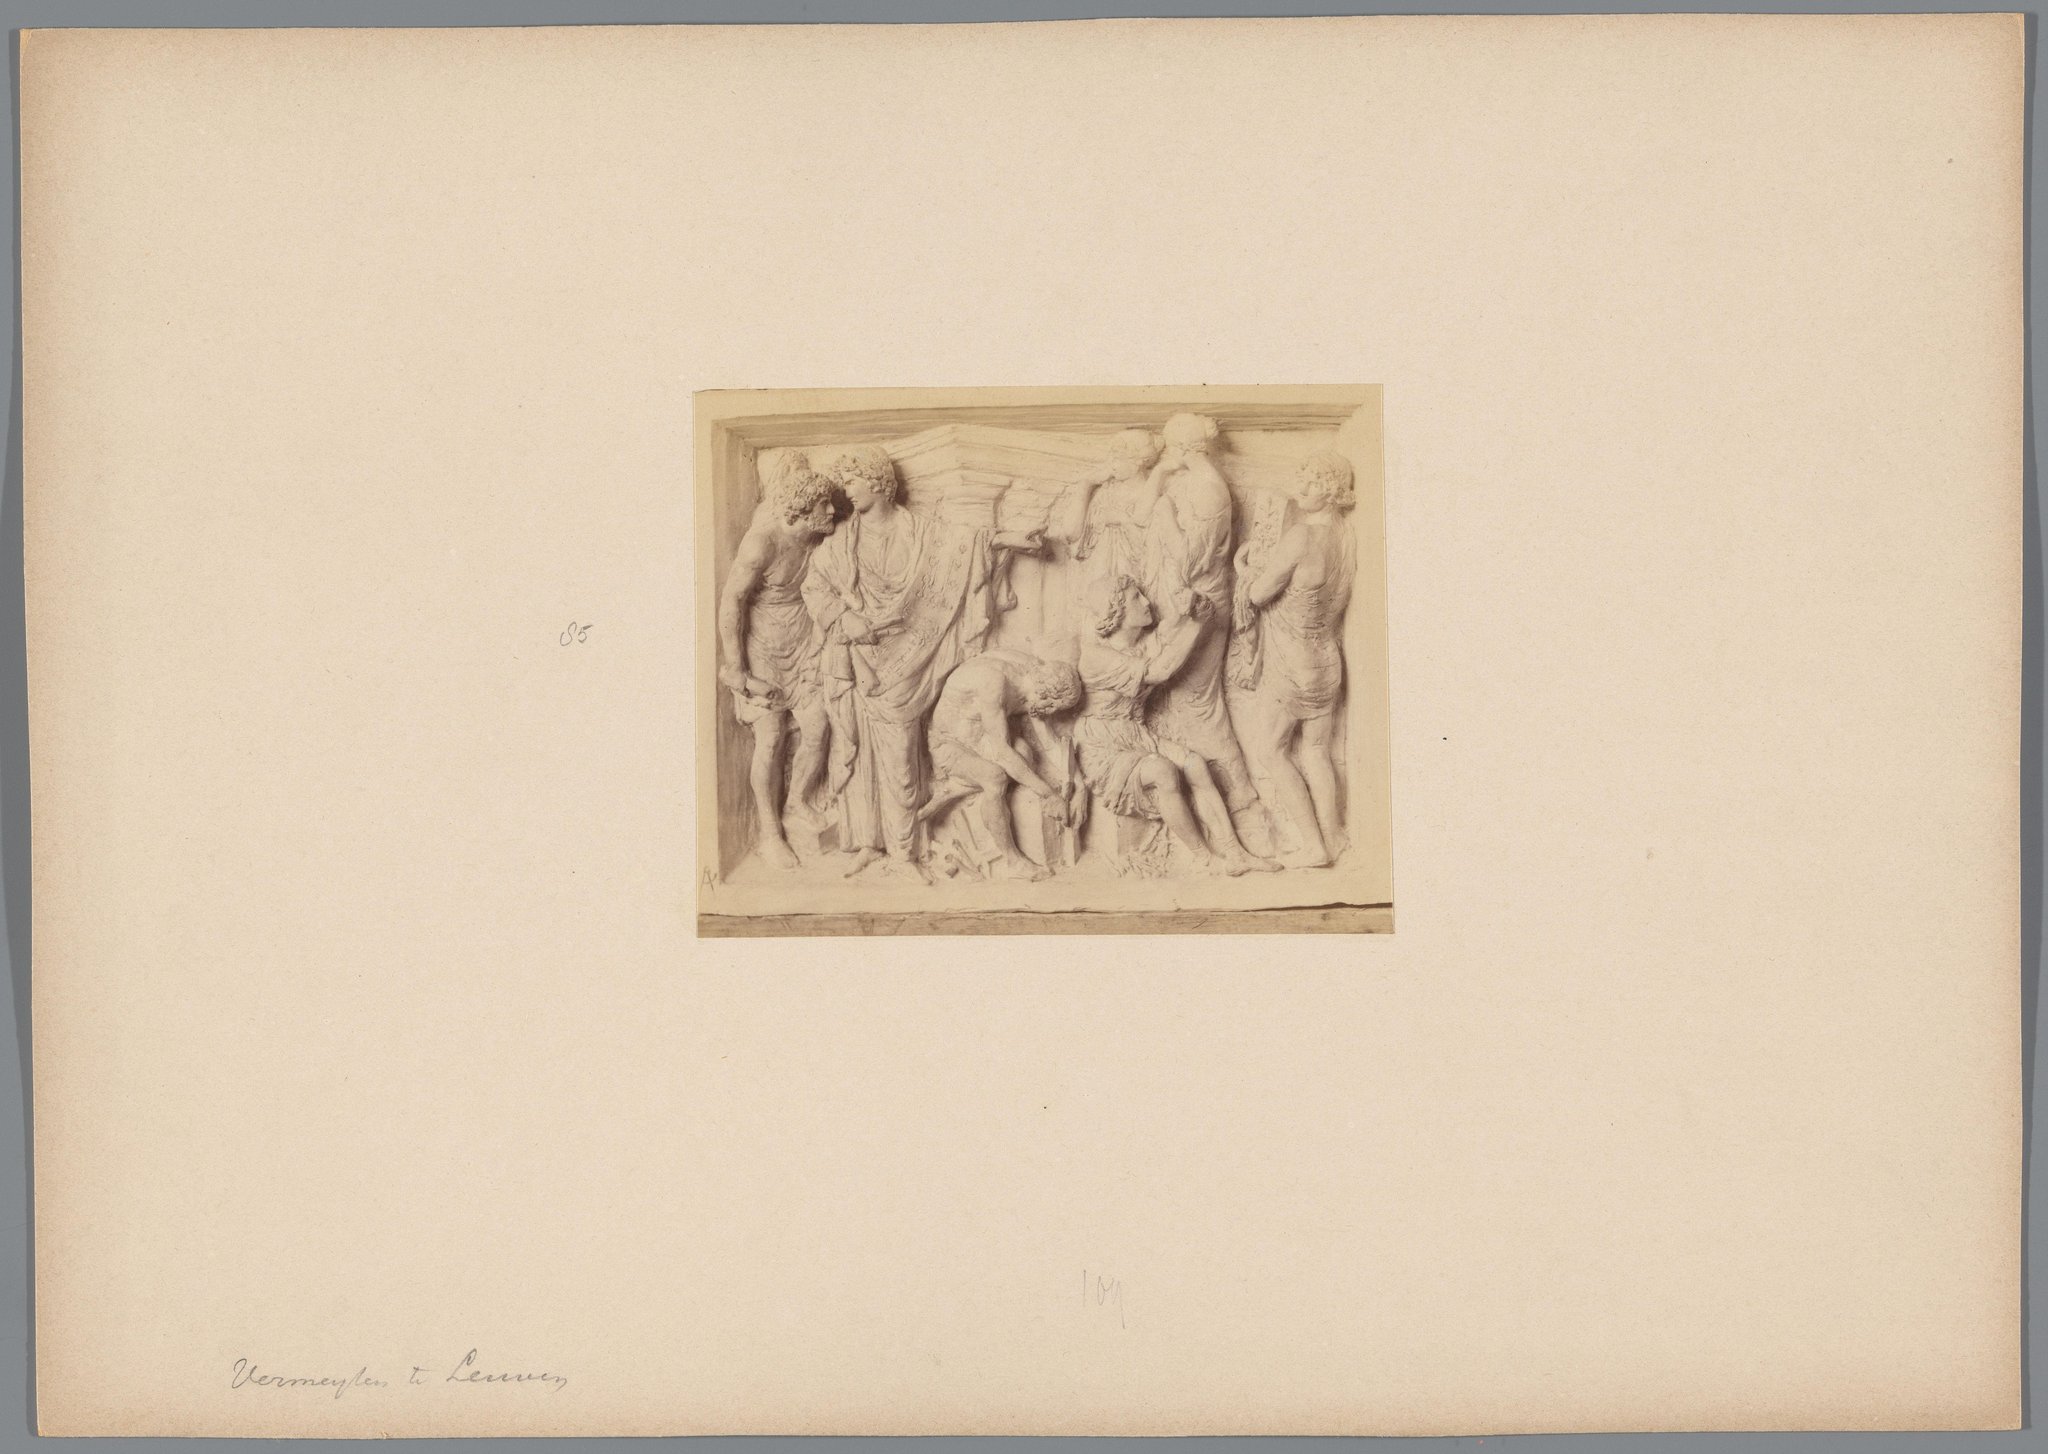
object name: photograph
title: Modellen van beeldhouwwerken voor een prijsvraag uitgeschreven door het Rijksmuseum Amsterdam, 1880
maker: Anonymous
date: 1880-1887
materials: cardboard, paper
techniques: albumen print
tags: the arts; artists, piece of sculpture, reproduction of a piece of sculpture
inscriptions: inscription: ‘109/ 85’, collector's mark: Lugt 2228, inscription: ‘Vermeylen te Leuven’